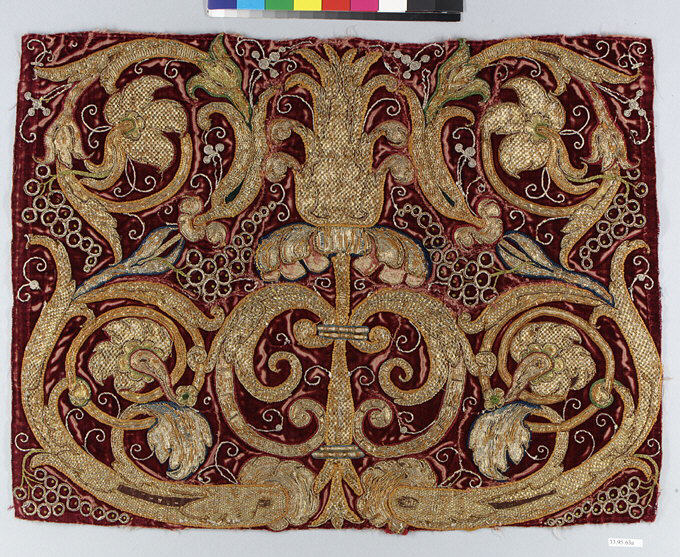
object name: clothing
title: Golden tendrils against a red ground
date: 1501-1600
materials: metal thread, silk, velvet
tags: flowers